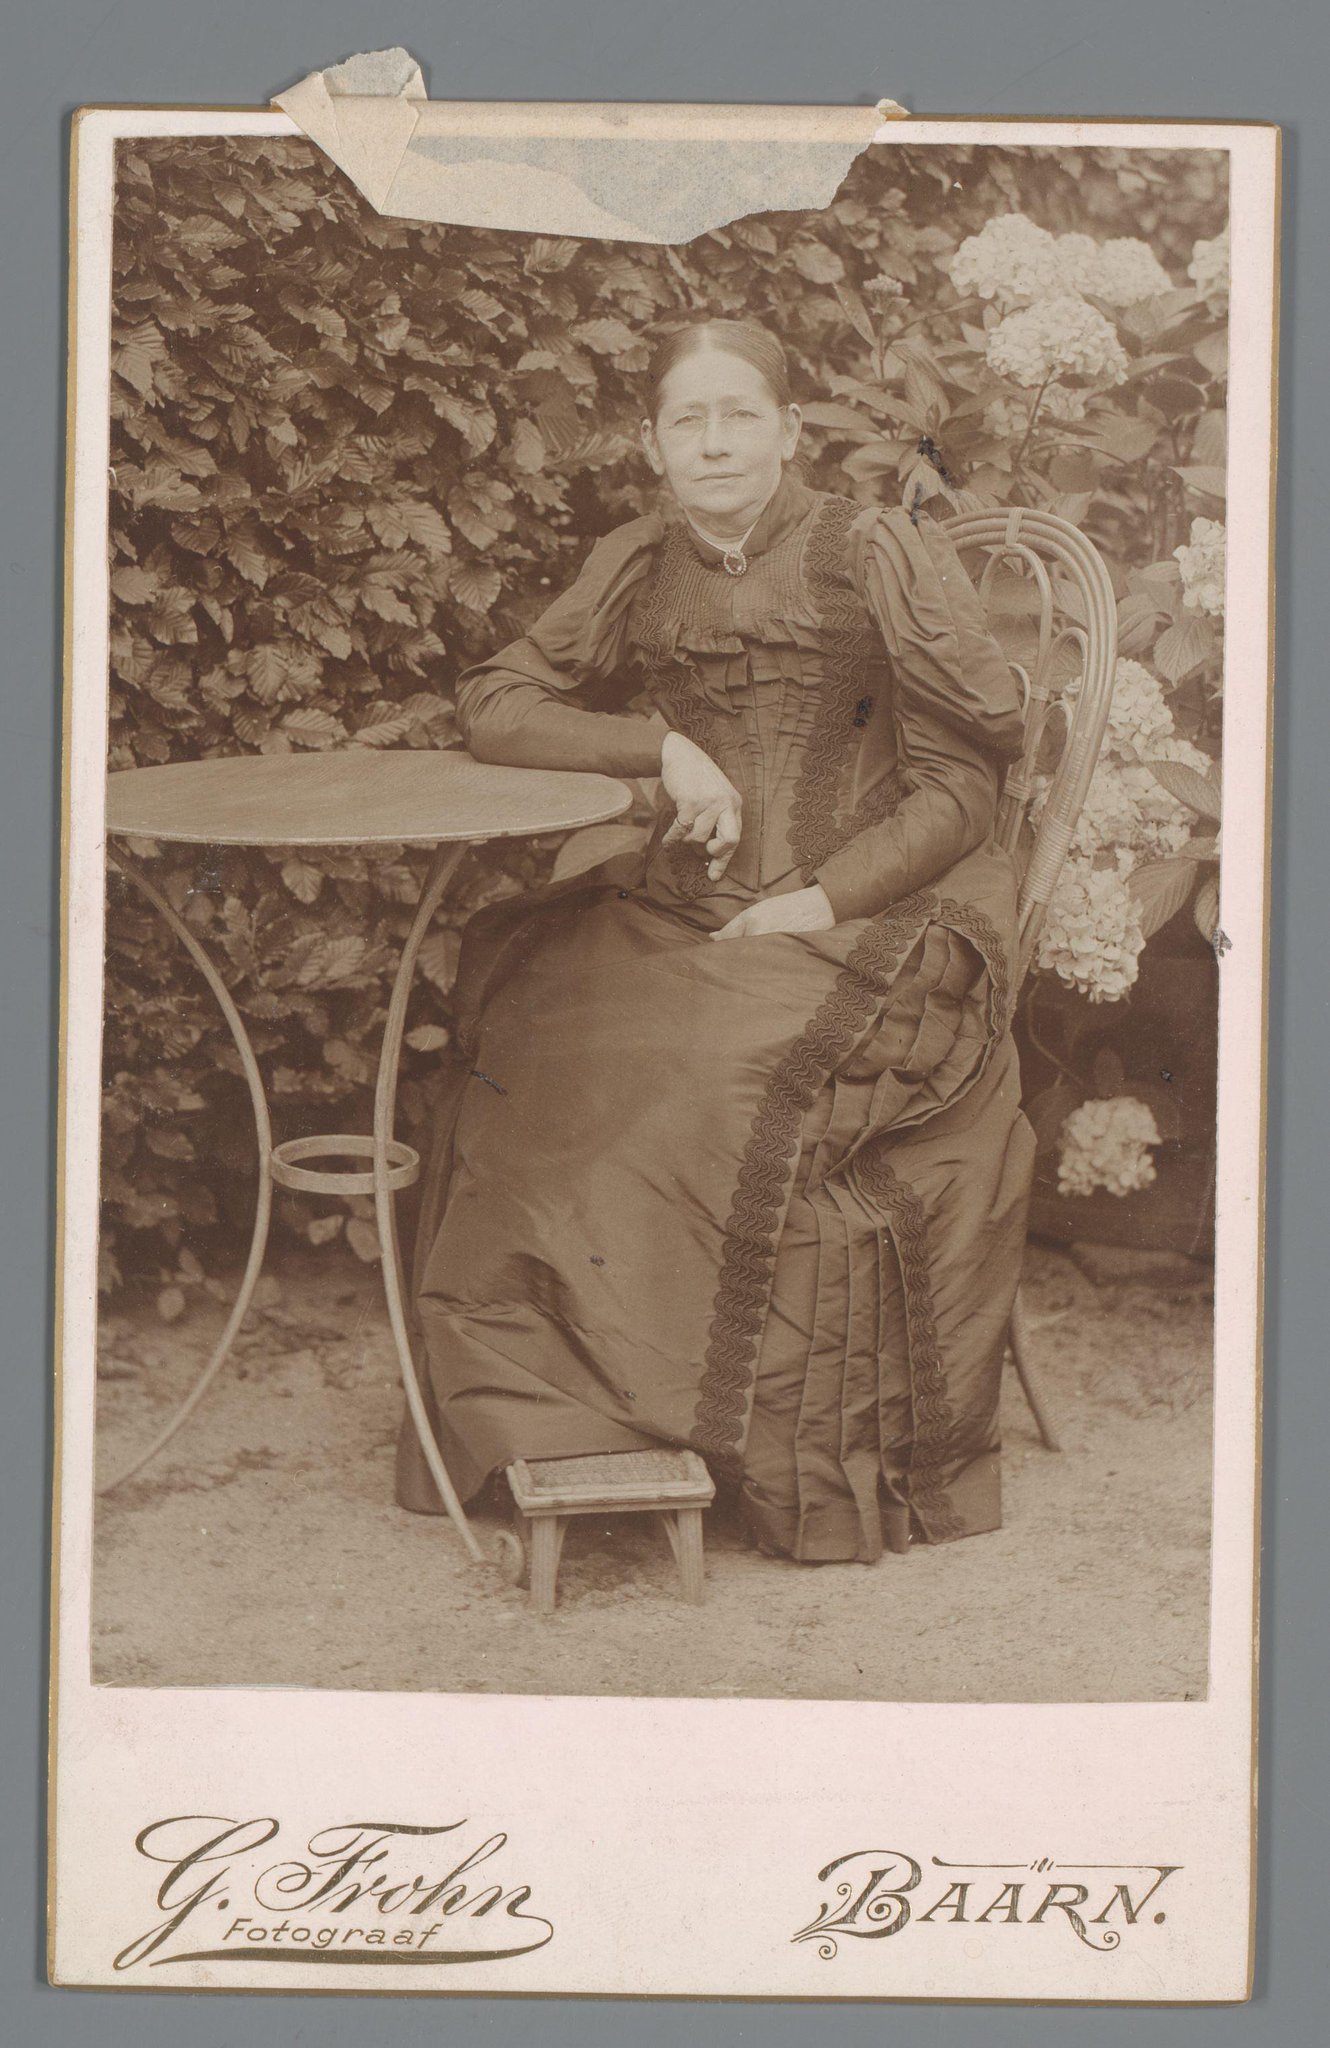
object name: photograph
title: Portret van Cornelia Hendrika Nije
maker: gerardus george johannes mathijs frohn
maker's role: fotograaf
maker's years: 1871-1910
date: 1890-1910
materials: cardboard, photographic support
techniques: collodion silver print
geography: baarn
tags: historical persons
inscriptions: annotation: ‘[...] Mevr. J.G. Jonker-Nije’